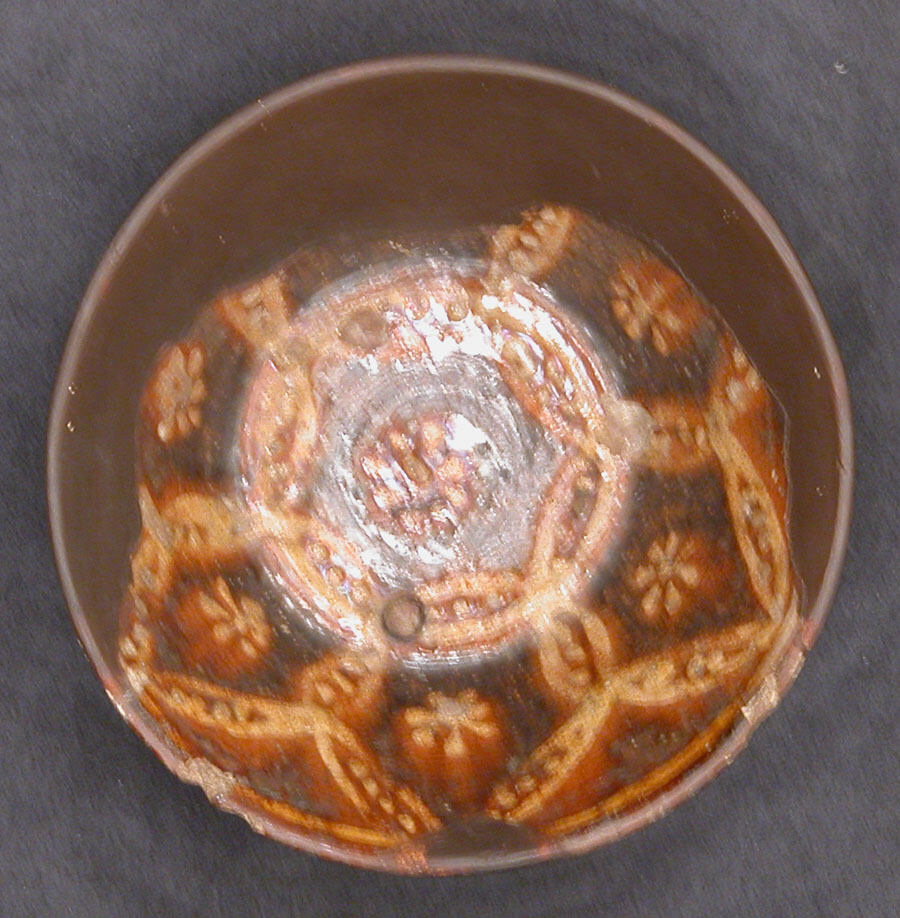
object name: bowl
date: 1301-1500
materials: earthenware, glaze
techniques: coloring, incising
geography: egypt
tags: flowers